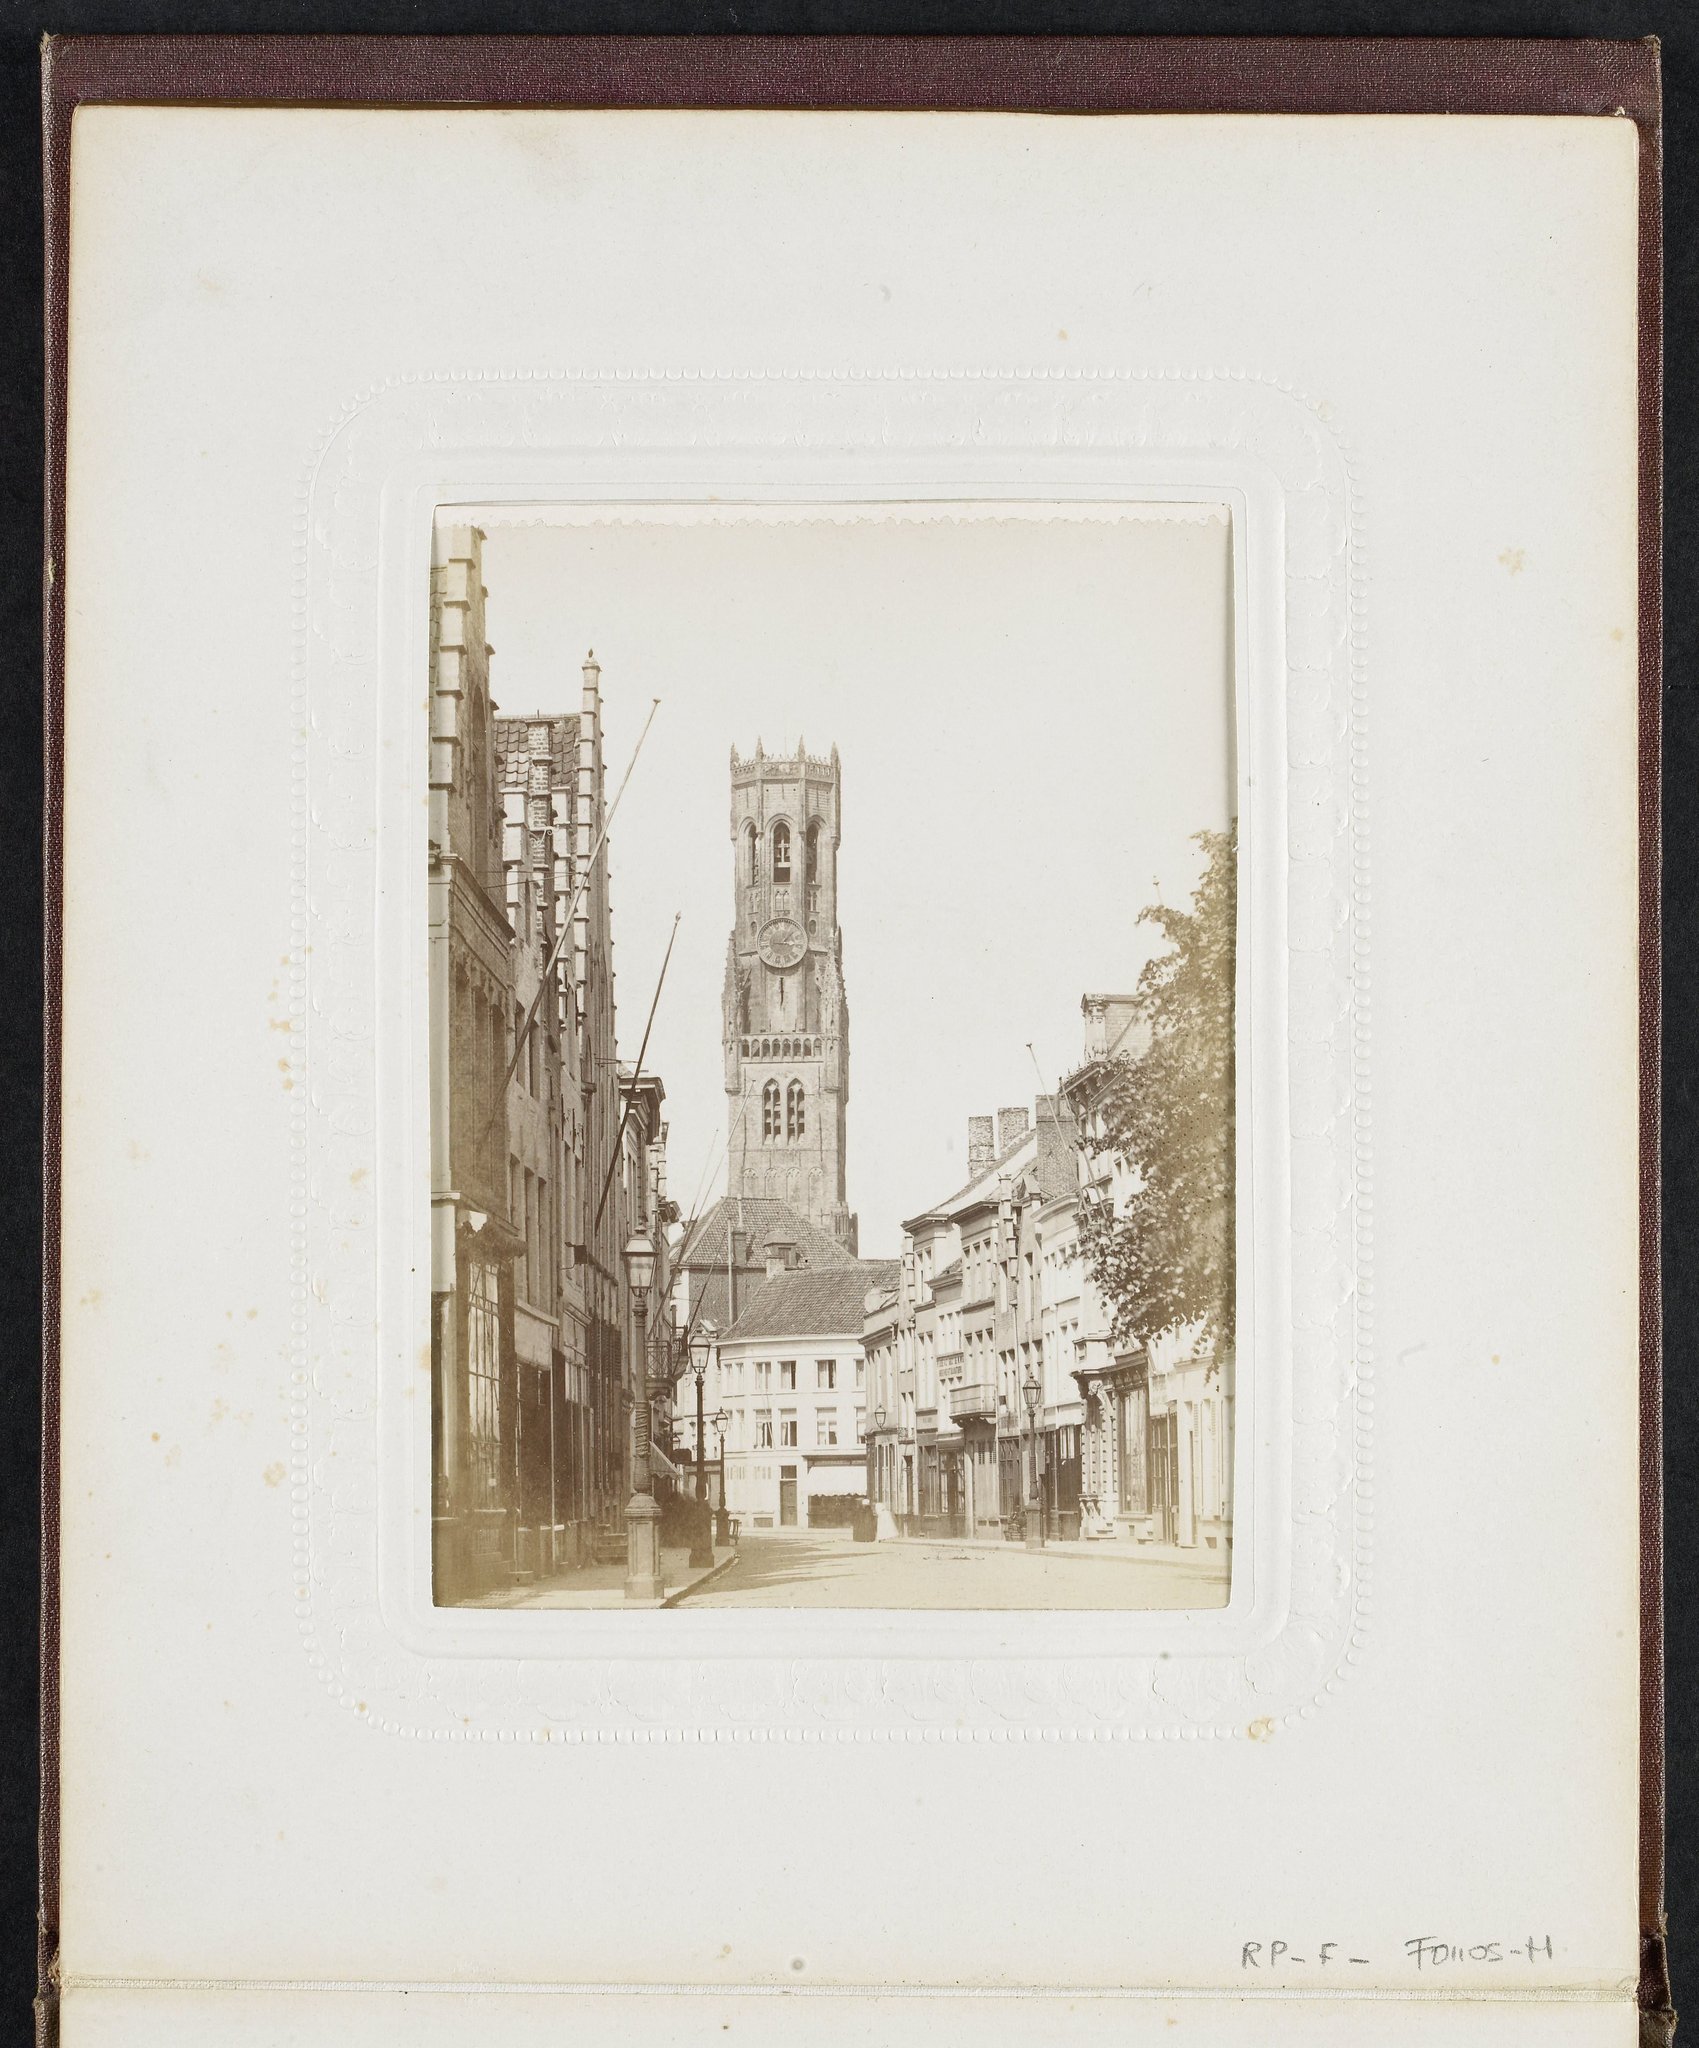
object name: album leaf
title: Steenstraat in Brugge met aan het einde het belfort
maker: victor daveluy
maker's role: fotograaf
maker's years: 1846-1886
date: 1860-1870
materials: cardboard, paper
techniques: albumen print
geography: bruges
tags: tower, clock tower ~ monumental adornment, city-view in general; 'veduta', street, bruges